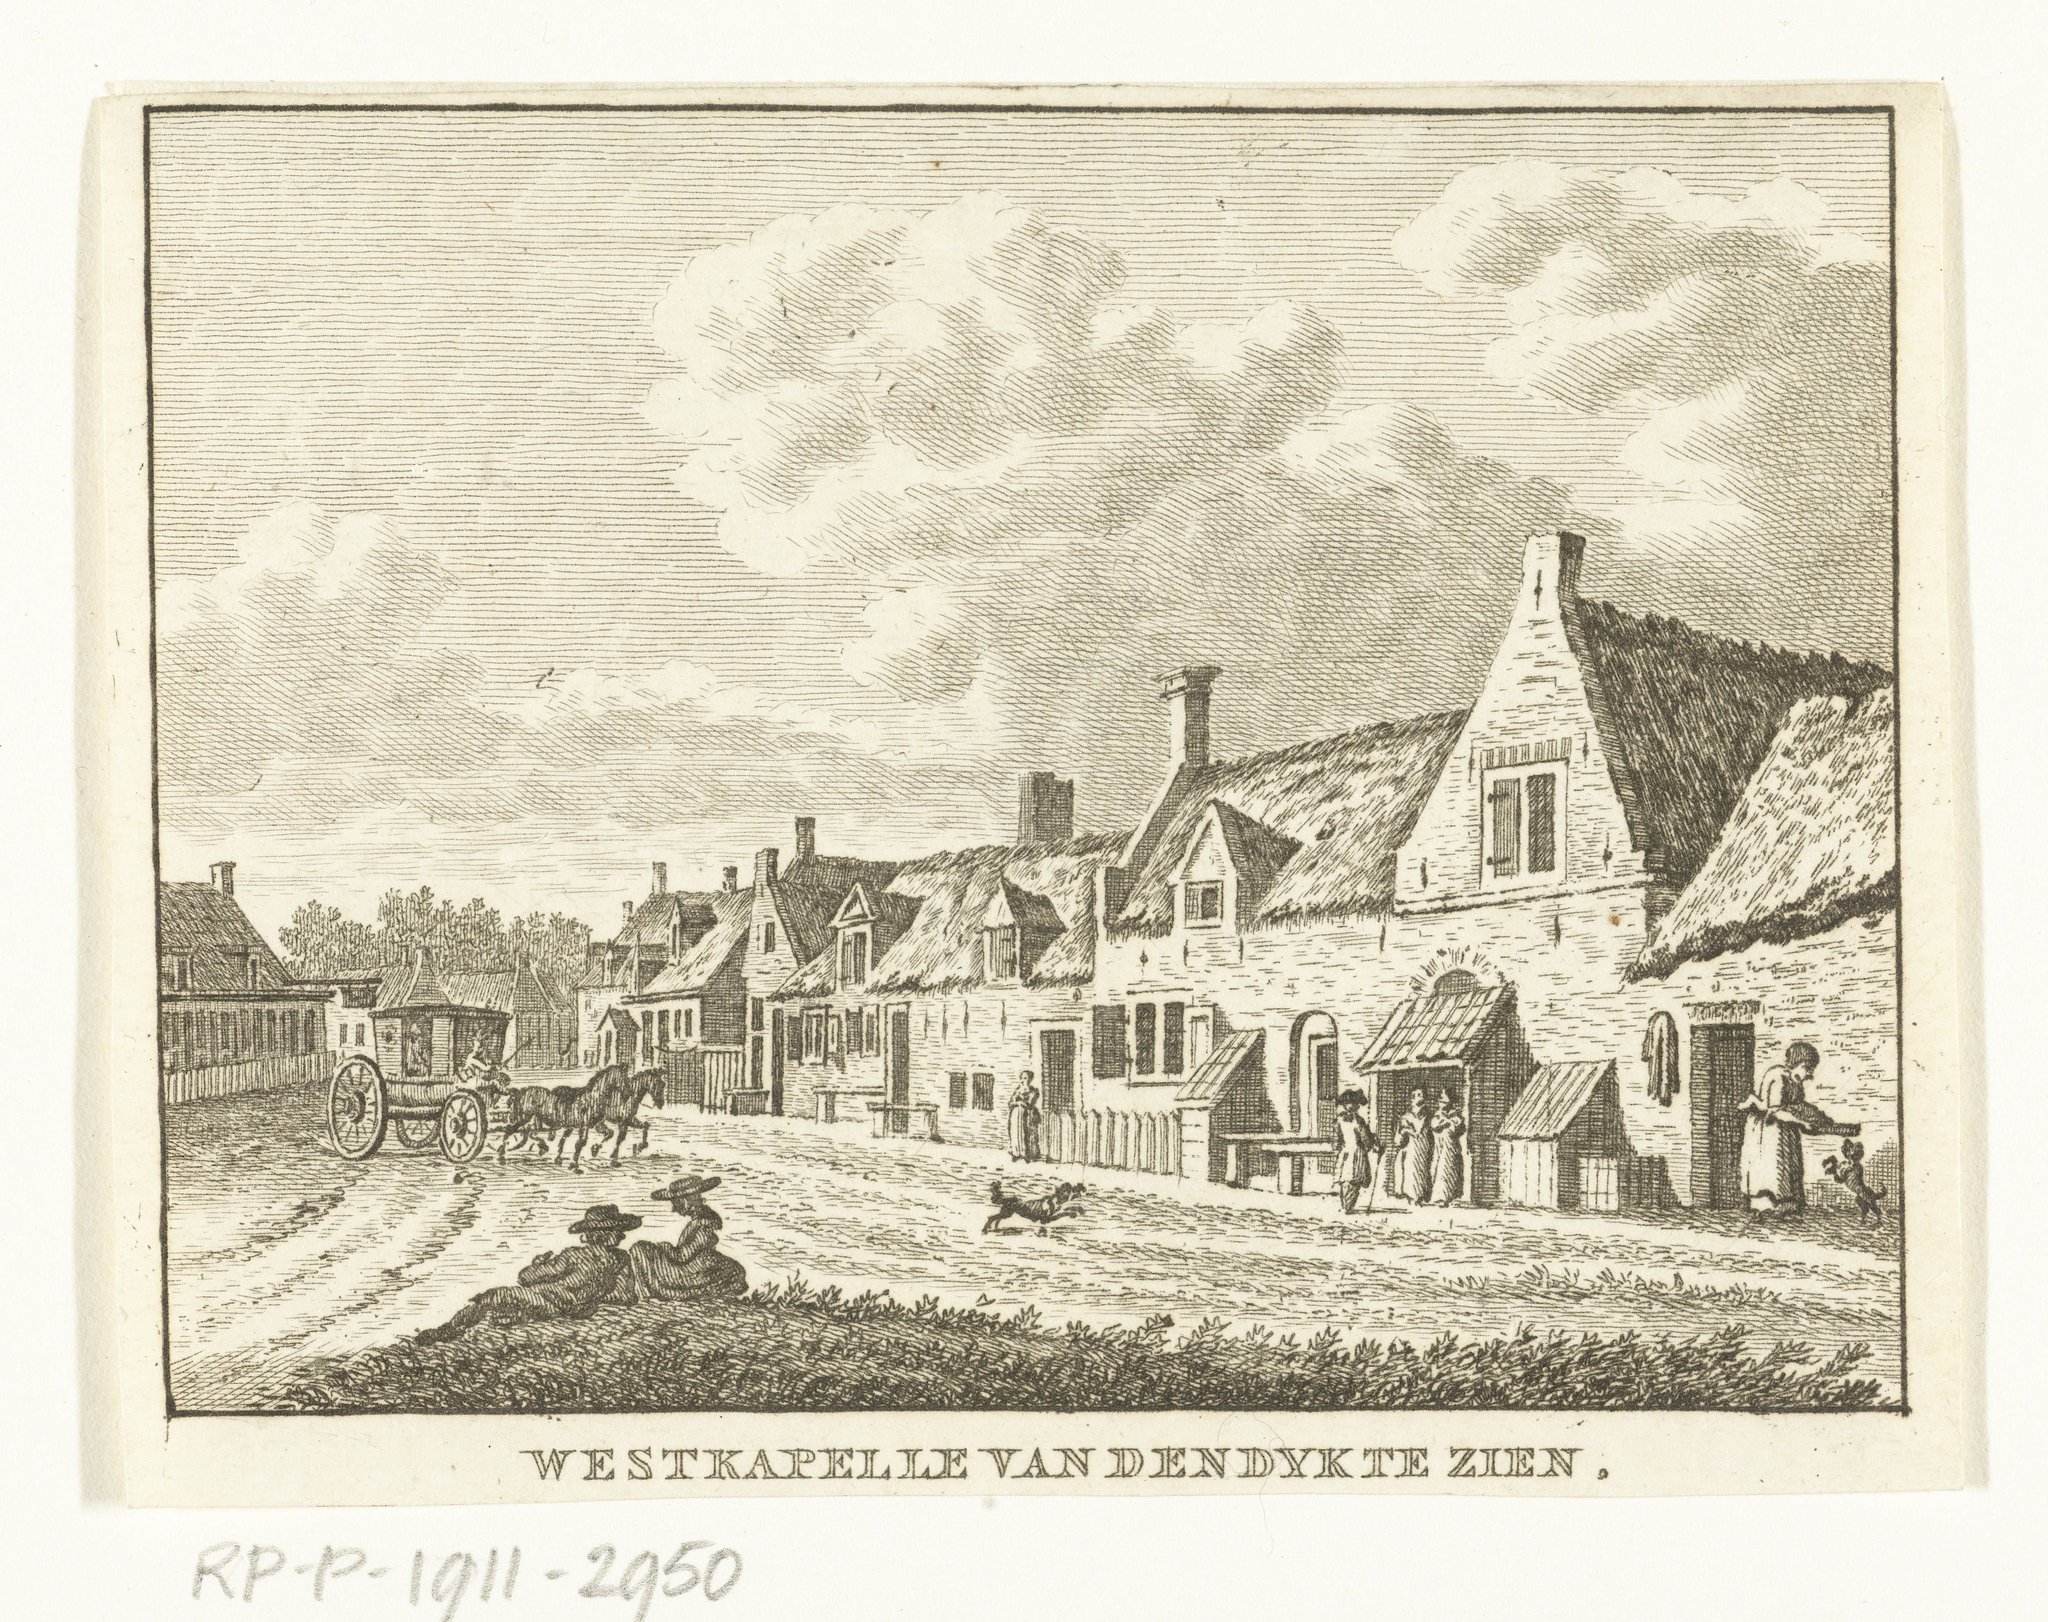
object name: print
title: Dorpsgezicht op de dijk te Westkapelle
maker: carel frederik bendorp (i)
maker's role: print maker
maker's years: 1736-1814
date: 1786-1792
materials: paper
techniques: etching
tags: village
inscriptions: collector's mark: Lugt 2228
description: Prent uit: Vaderlandsche gezichten, of afbeeldingen van den tegenwoordigen staat der Vereenigde Nederlanden (…). Amsterdam: Hendrik Gartman, Willem Vermandel en Jan Willem Smit, 1786-1792. Uitgegeven in afleveringen met ieder een eigen bifolium en inhoudsopgave. Alle prenten in deze publicatie zijn gegraveerd door Carel Frederik Bendorp (I) en, in de meeste gevallen, gebaseerd op tekeningen van Jan Bulthuis. Prent afgesneden van blad met twee voorstellingen.